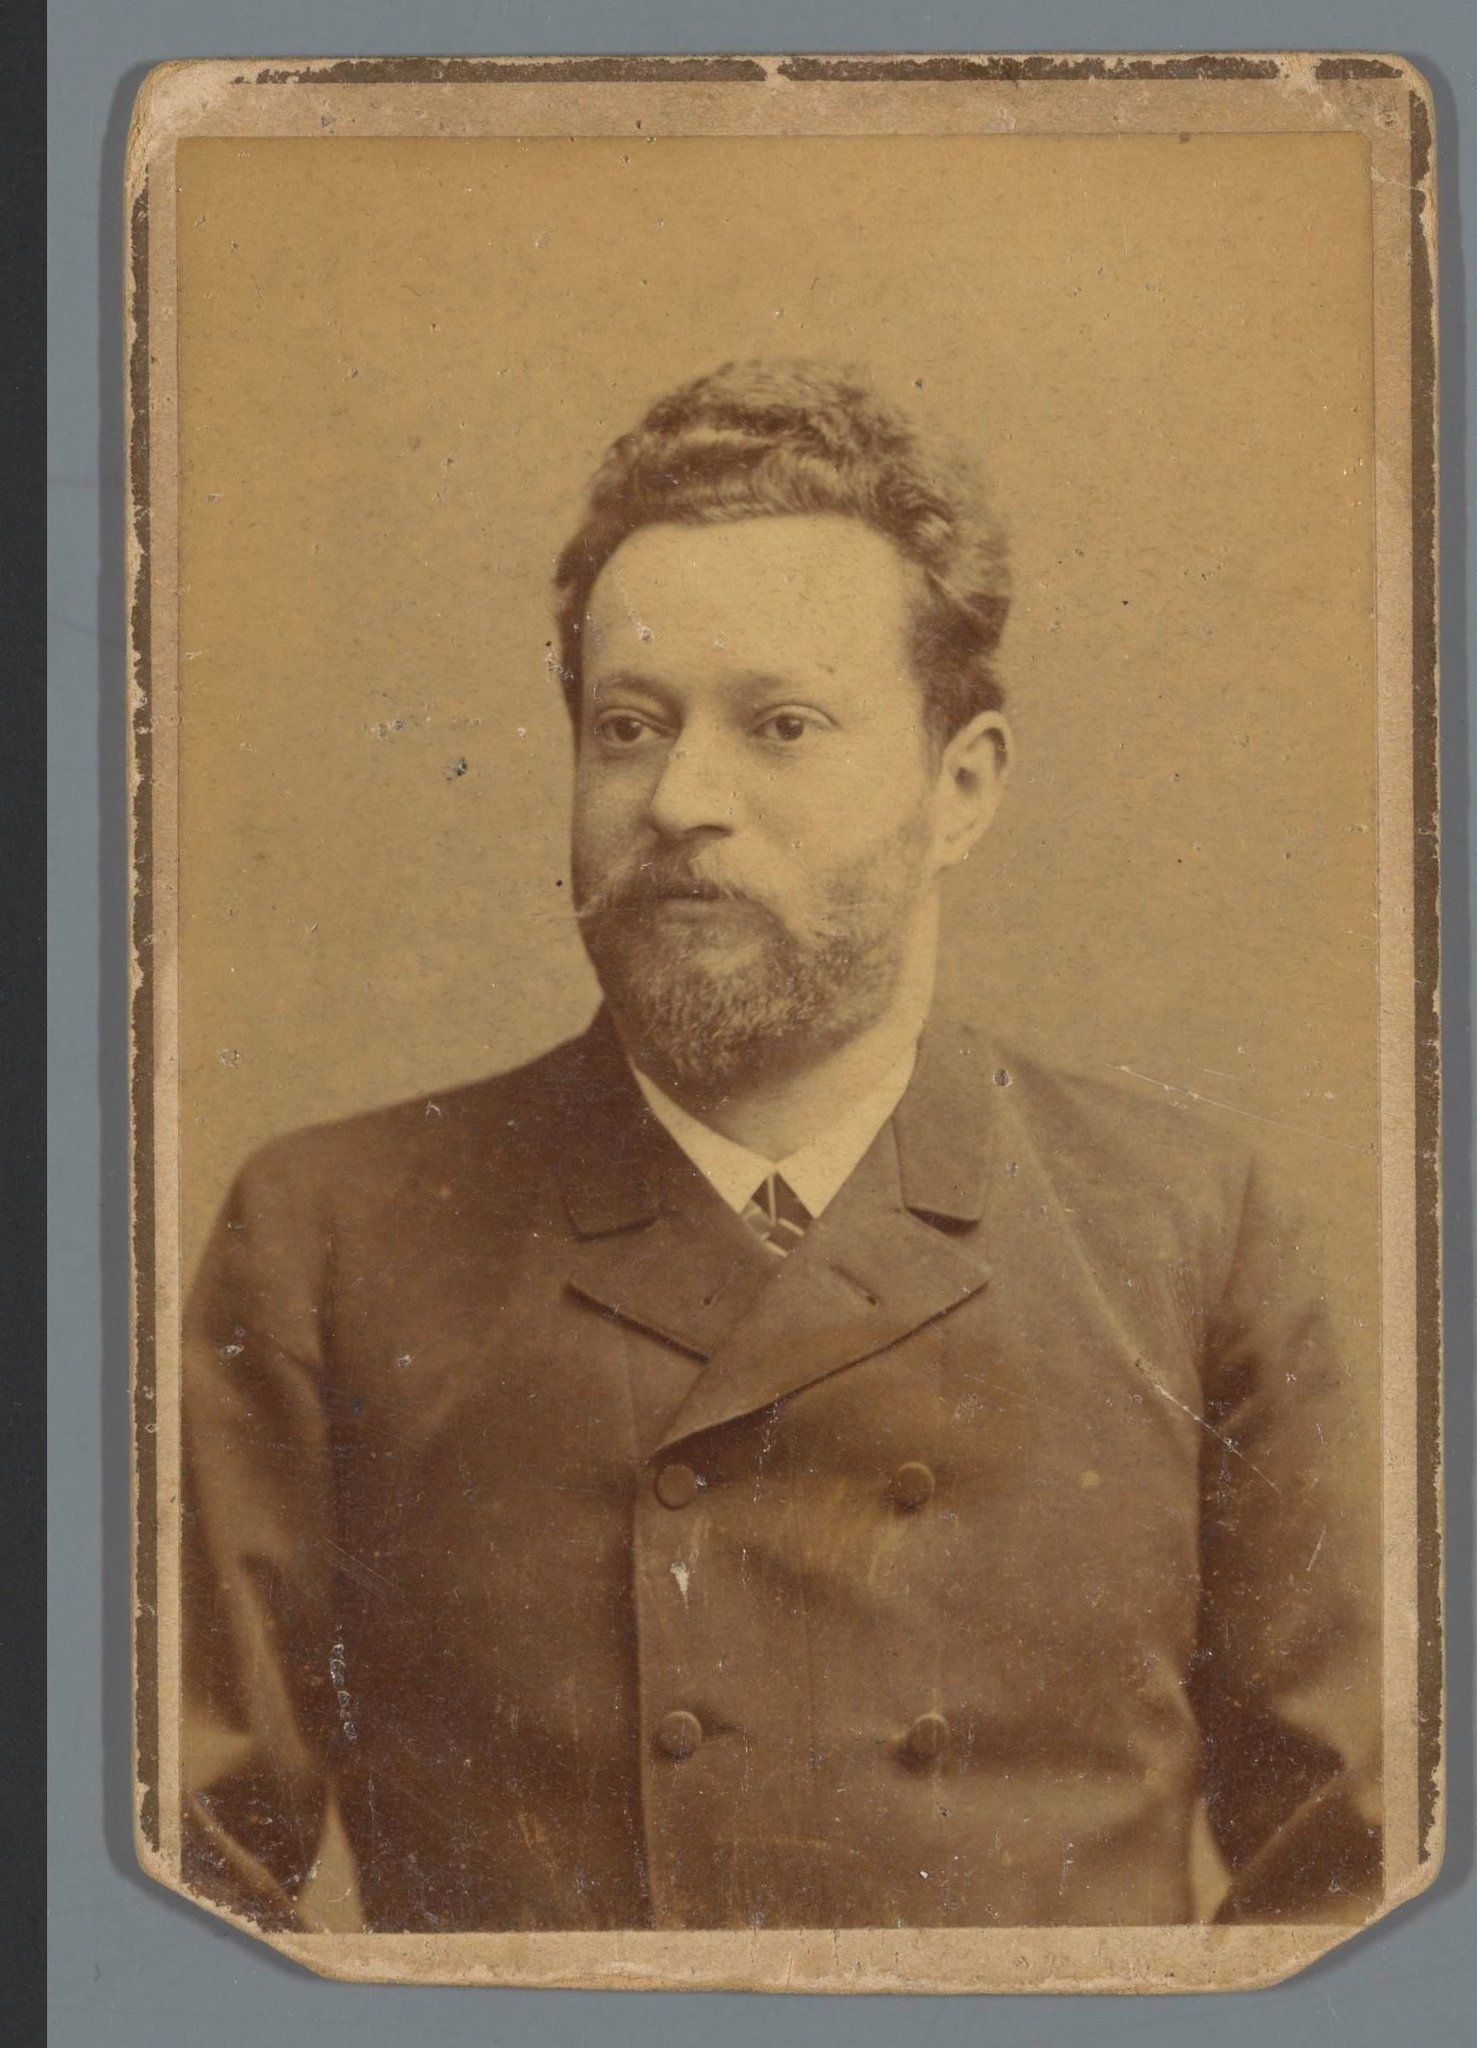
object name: carte de visite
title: Portret van een onbekende man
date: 1855-1885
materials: cardboard, paper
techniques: albumen print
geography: cologne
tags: adult man, anonymous historical person portrayed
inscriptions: address: ‘39. Passage 39,/ Köln.’